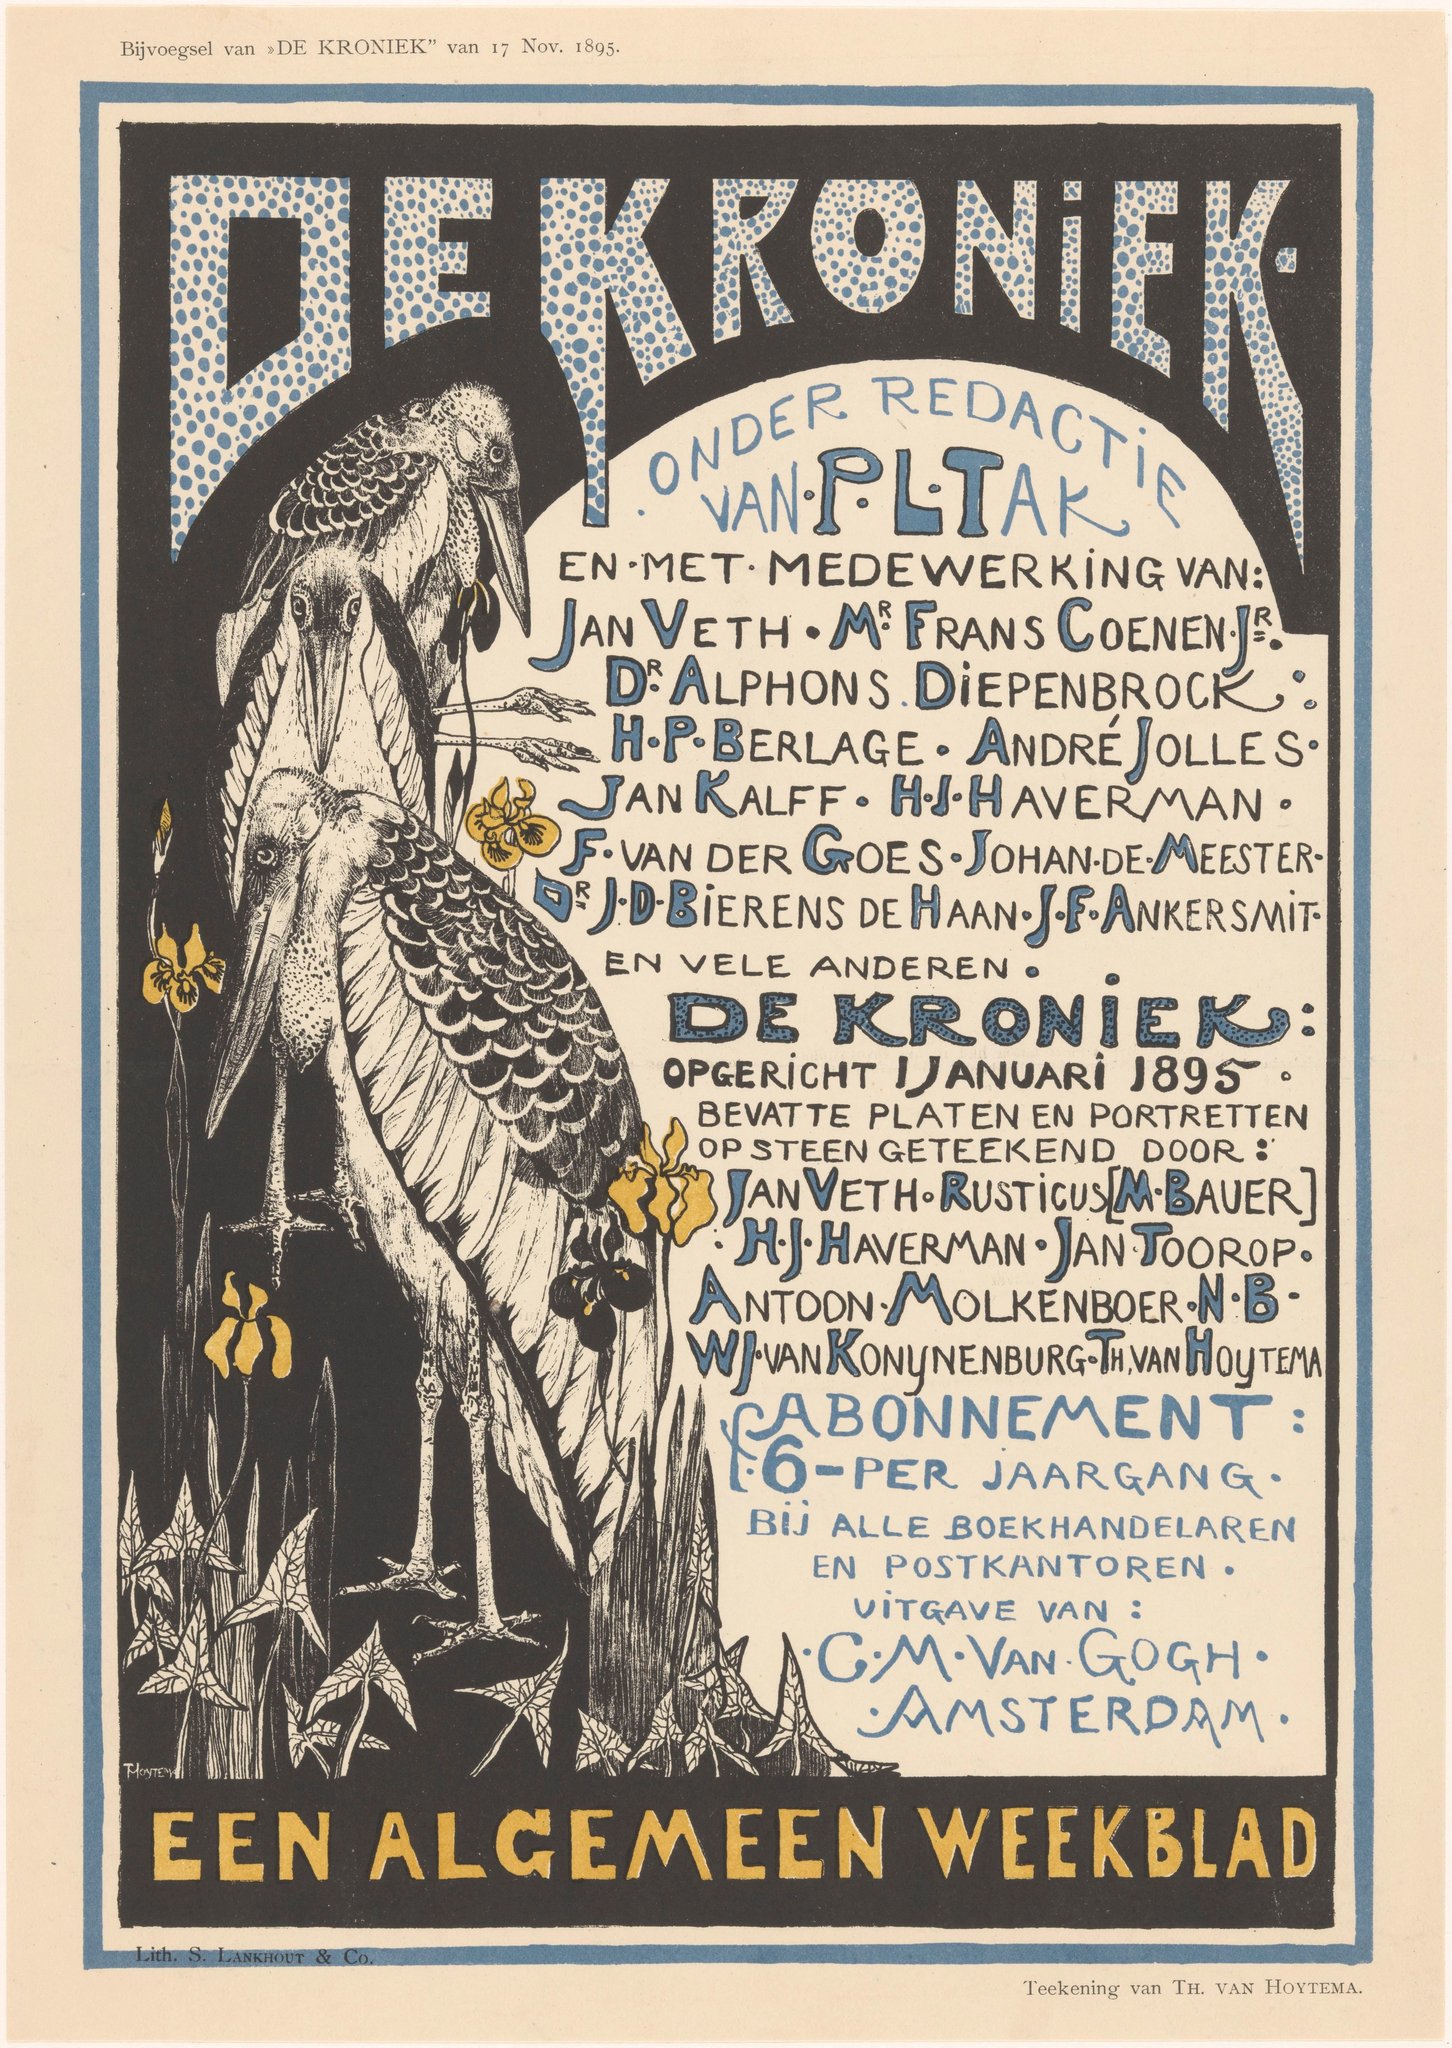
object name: advertising card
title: Reclamekaart voor 'De Kroniek'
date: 1895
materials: paper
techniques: letterpress printing, lithograph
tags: shore-birds and wading-birds: marabou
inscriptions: collector's mark: Lugt 2233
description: Links naast de tekst drie maraboes tussen lelies en waterplanten.